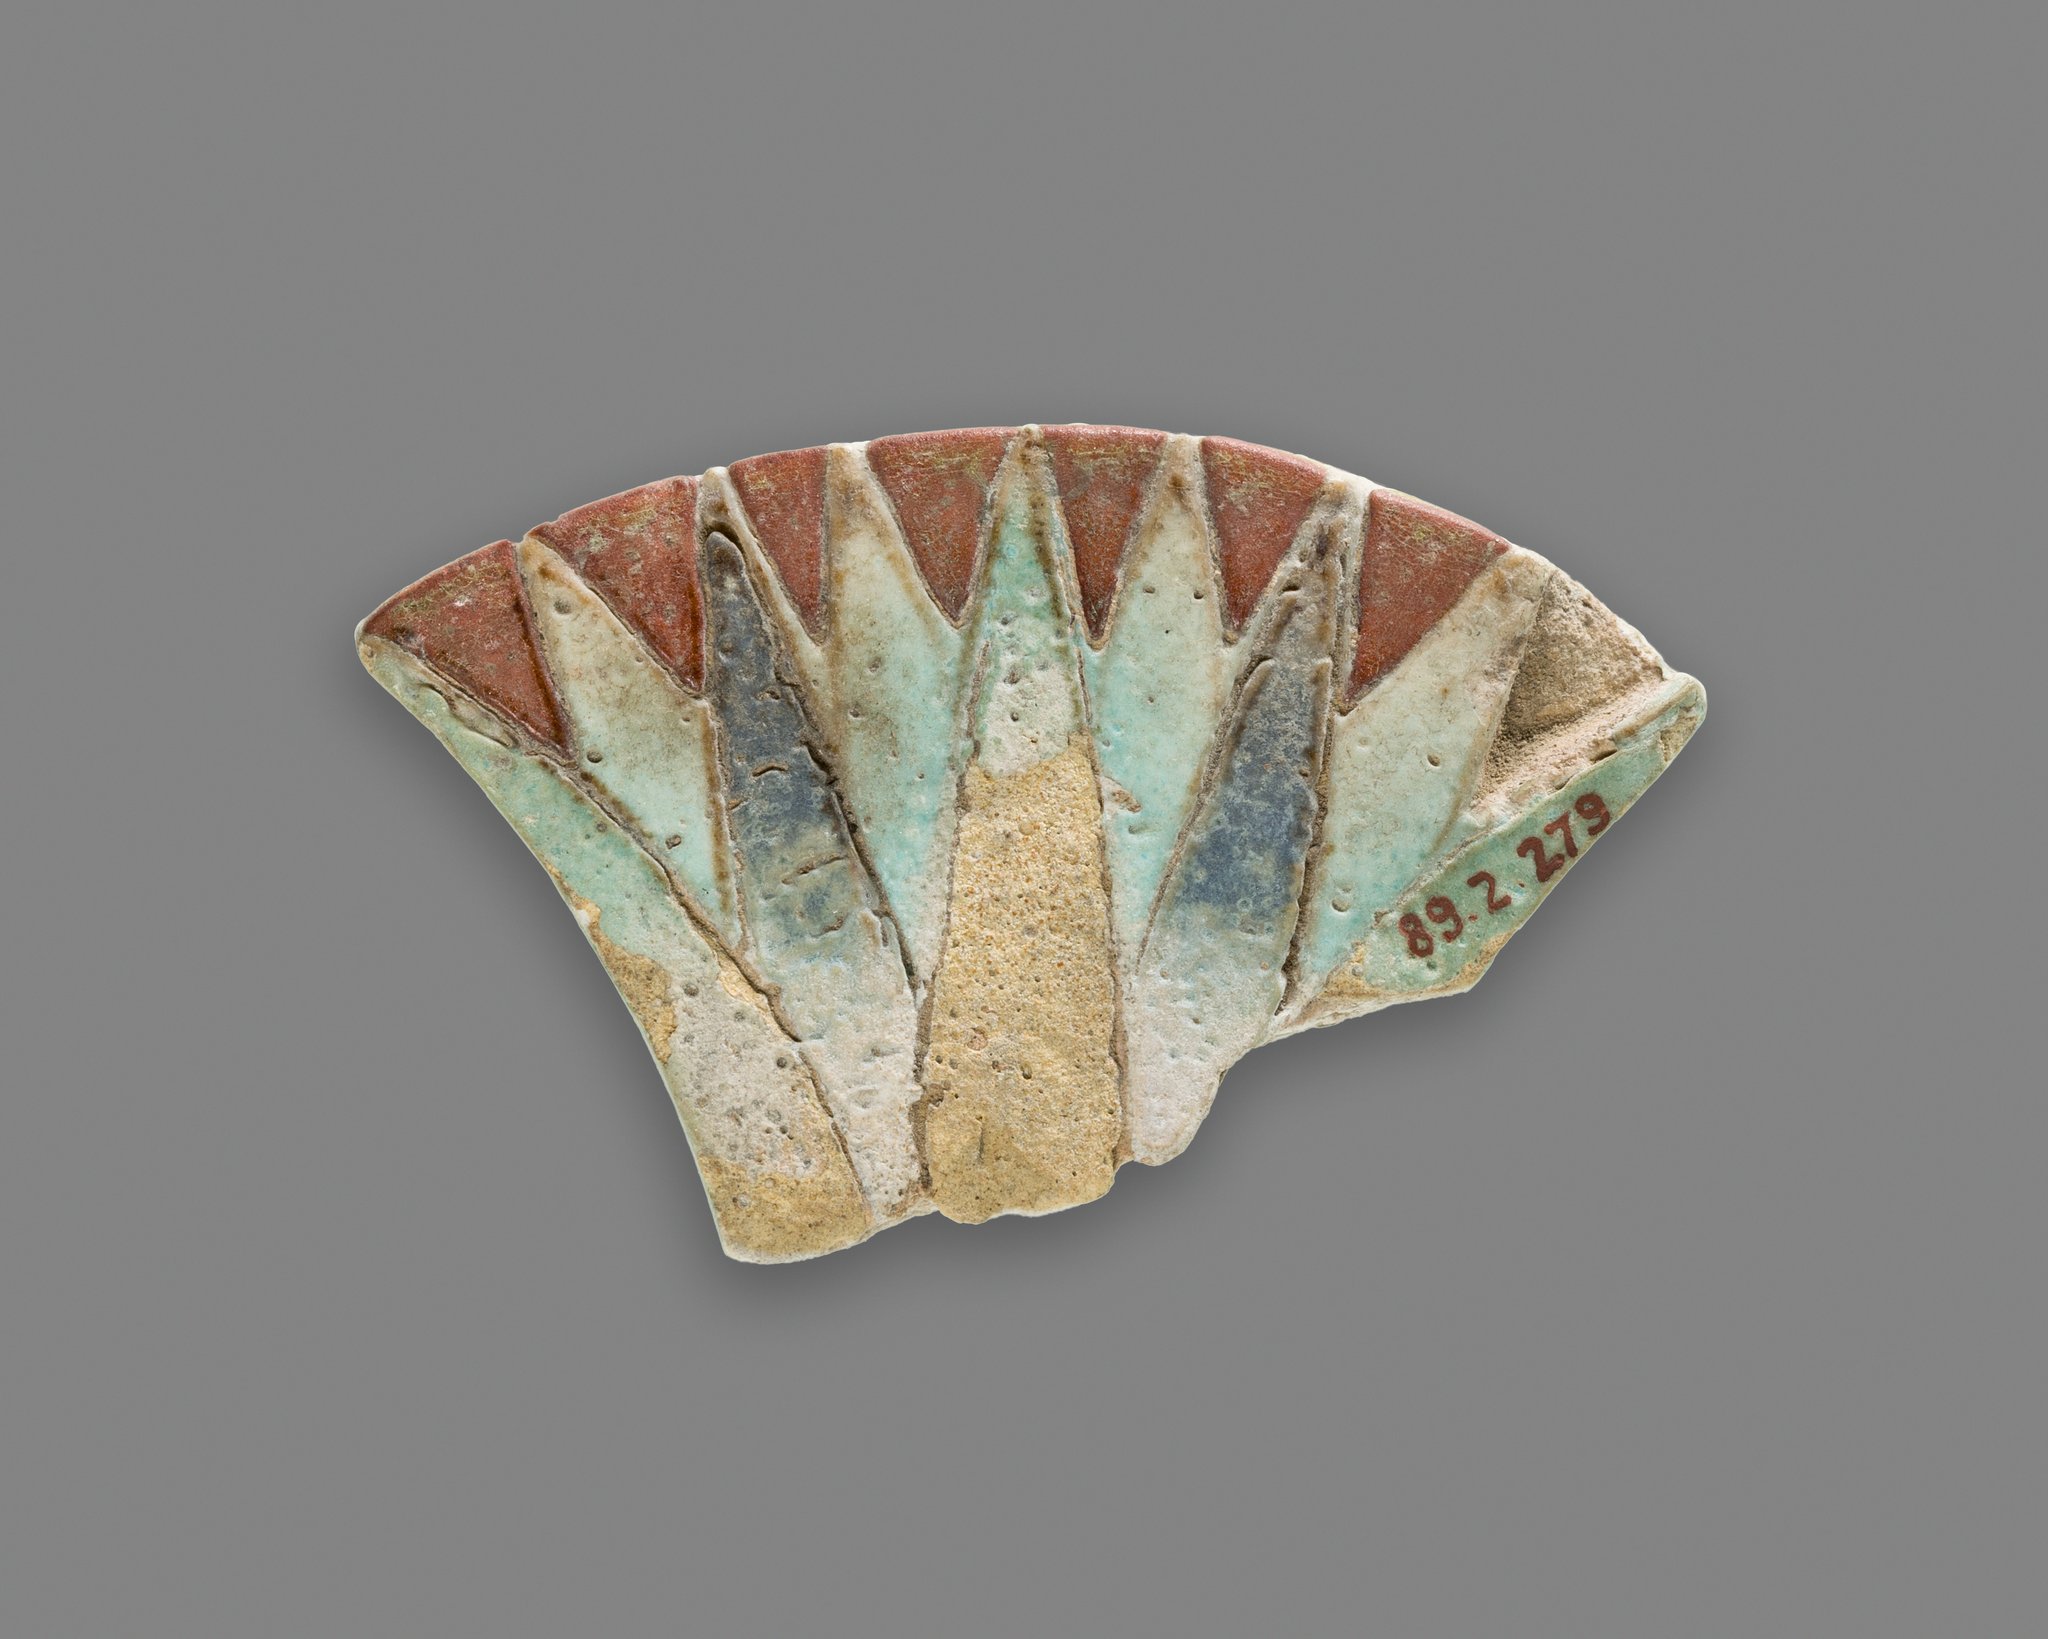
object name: inlay, lotus, lily, bud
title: Faience Inlay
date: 1184-1153 BCE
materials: faience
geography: egypt